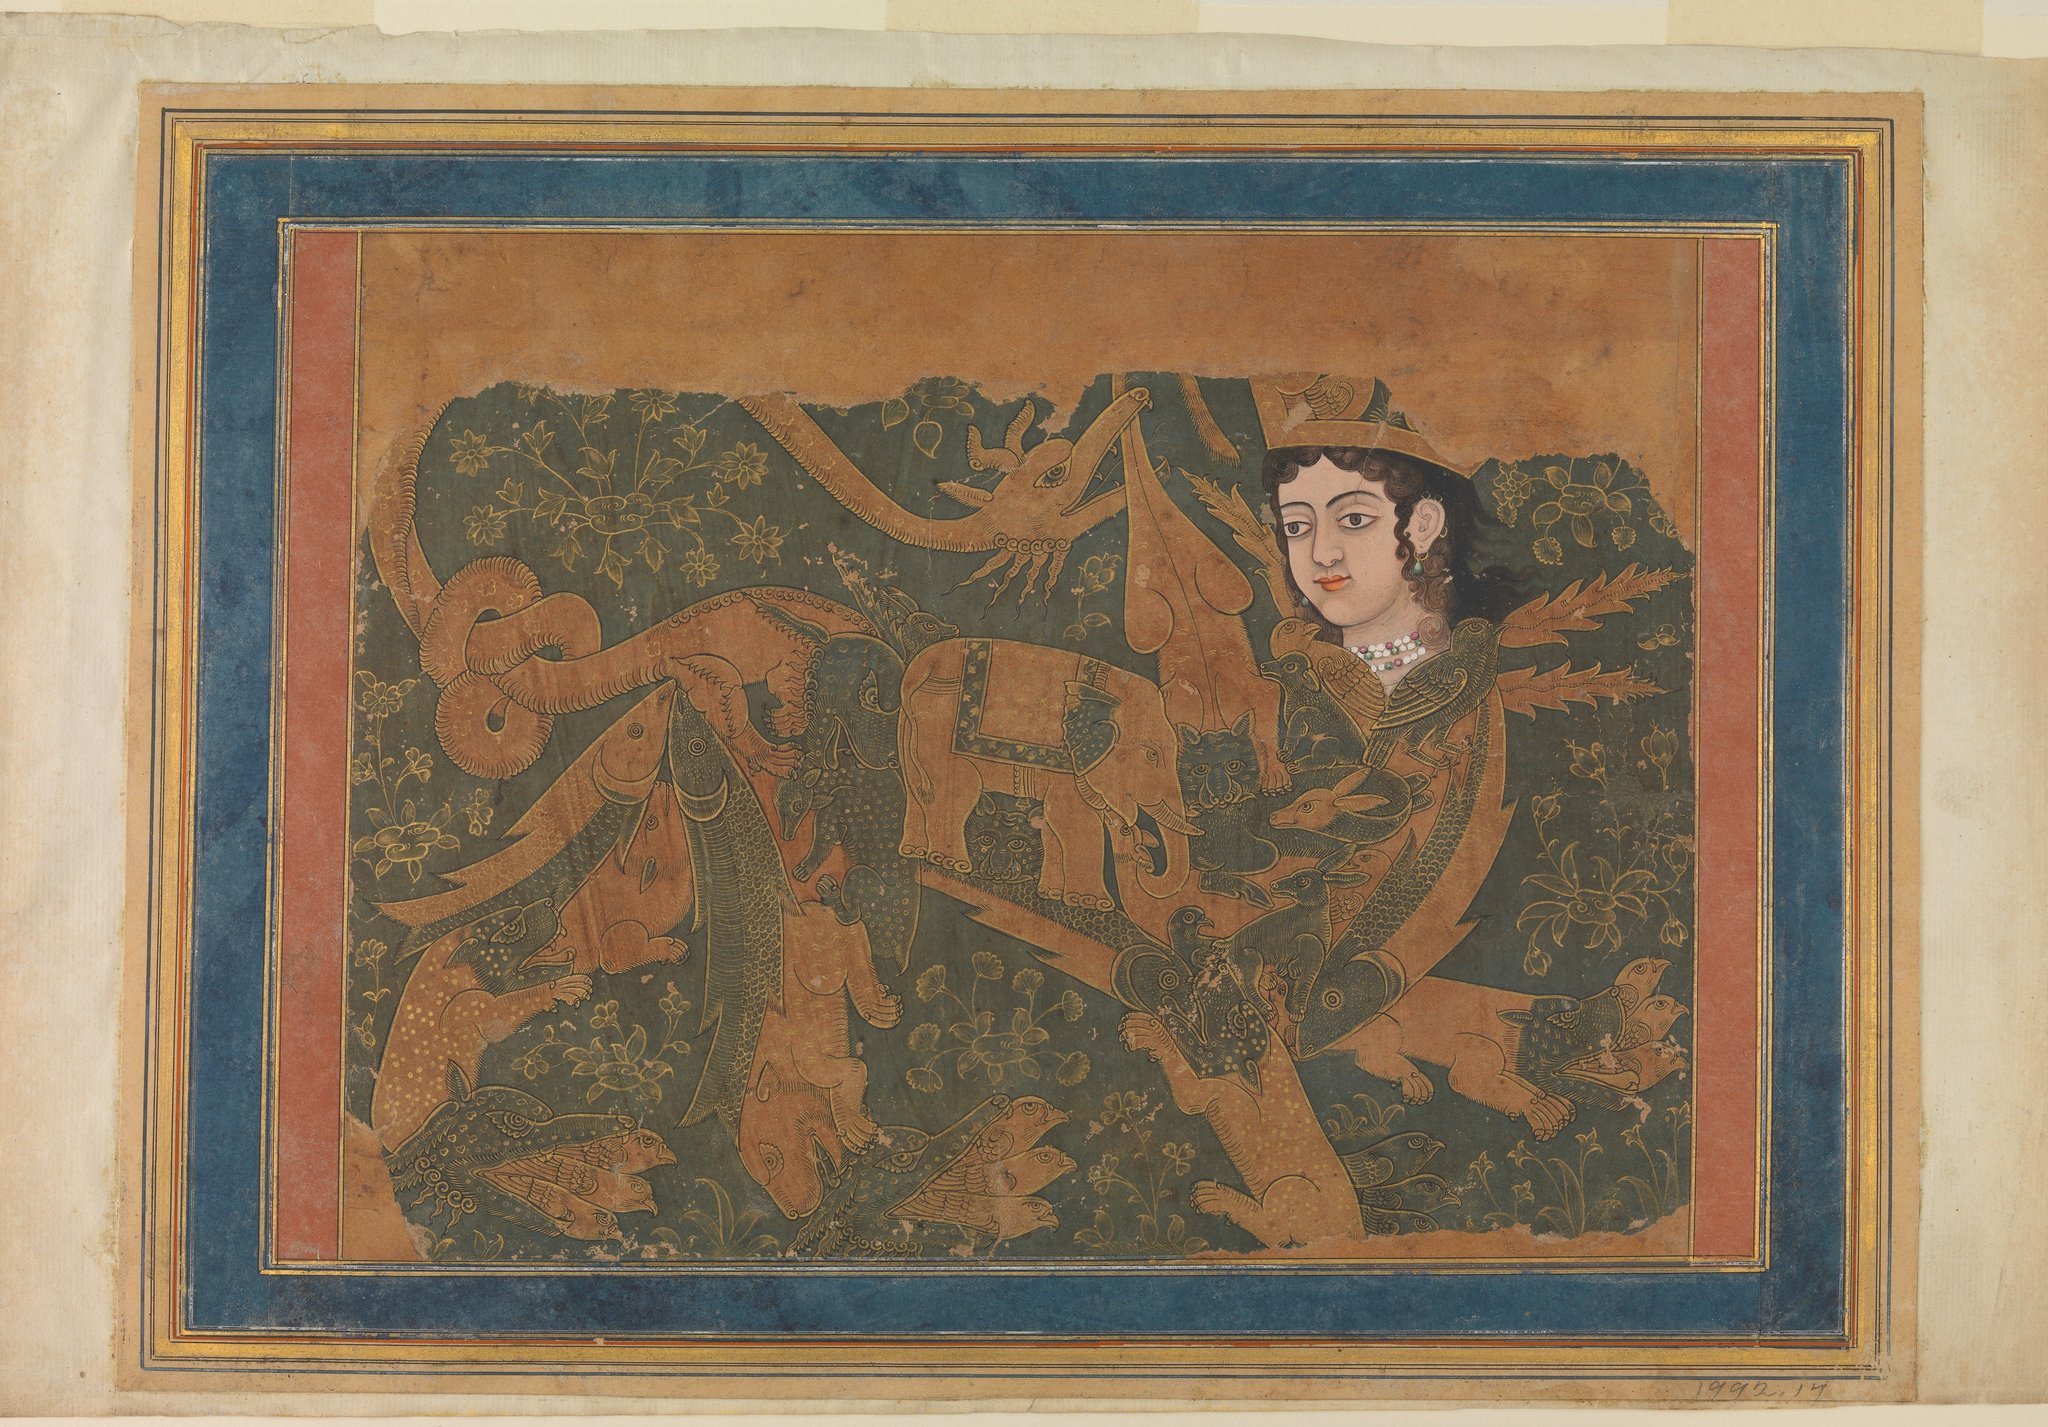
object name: illustrated single work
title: The Fabulous Creature Buraq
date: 1660-1680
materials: gold, paper, watercolor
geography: india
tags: birds,faces,mythical creatures,elephants,fish